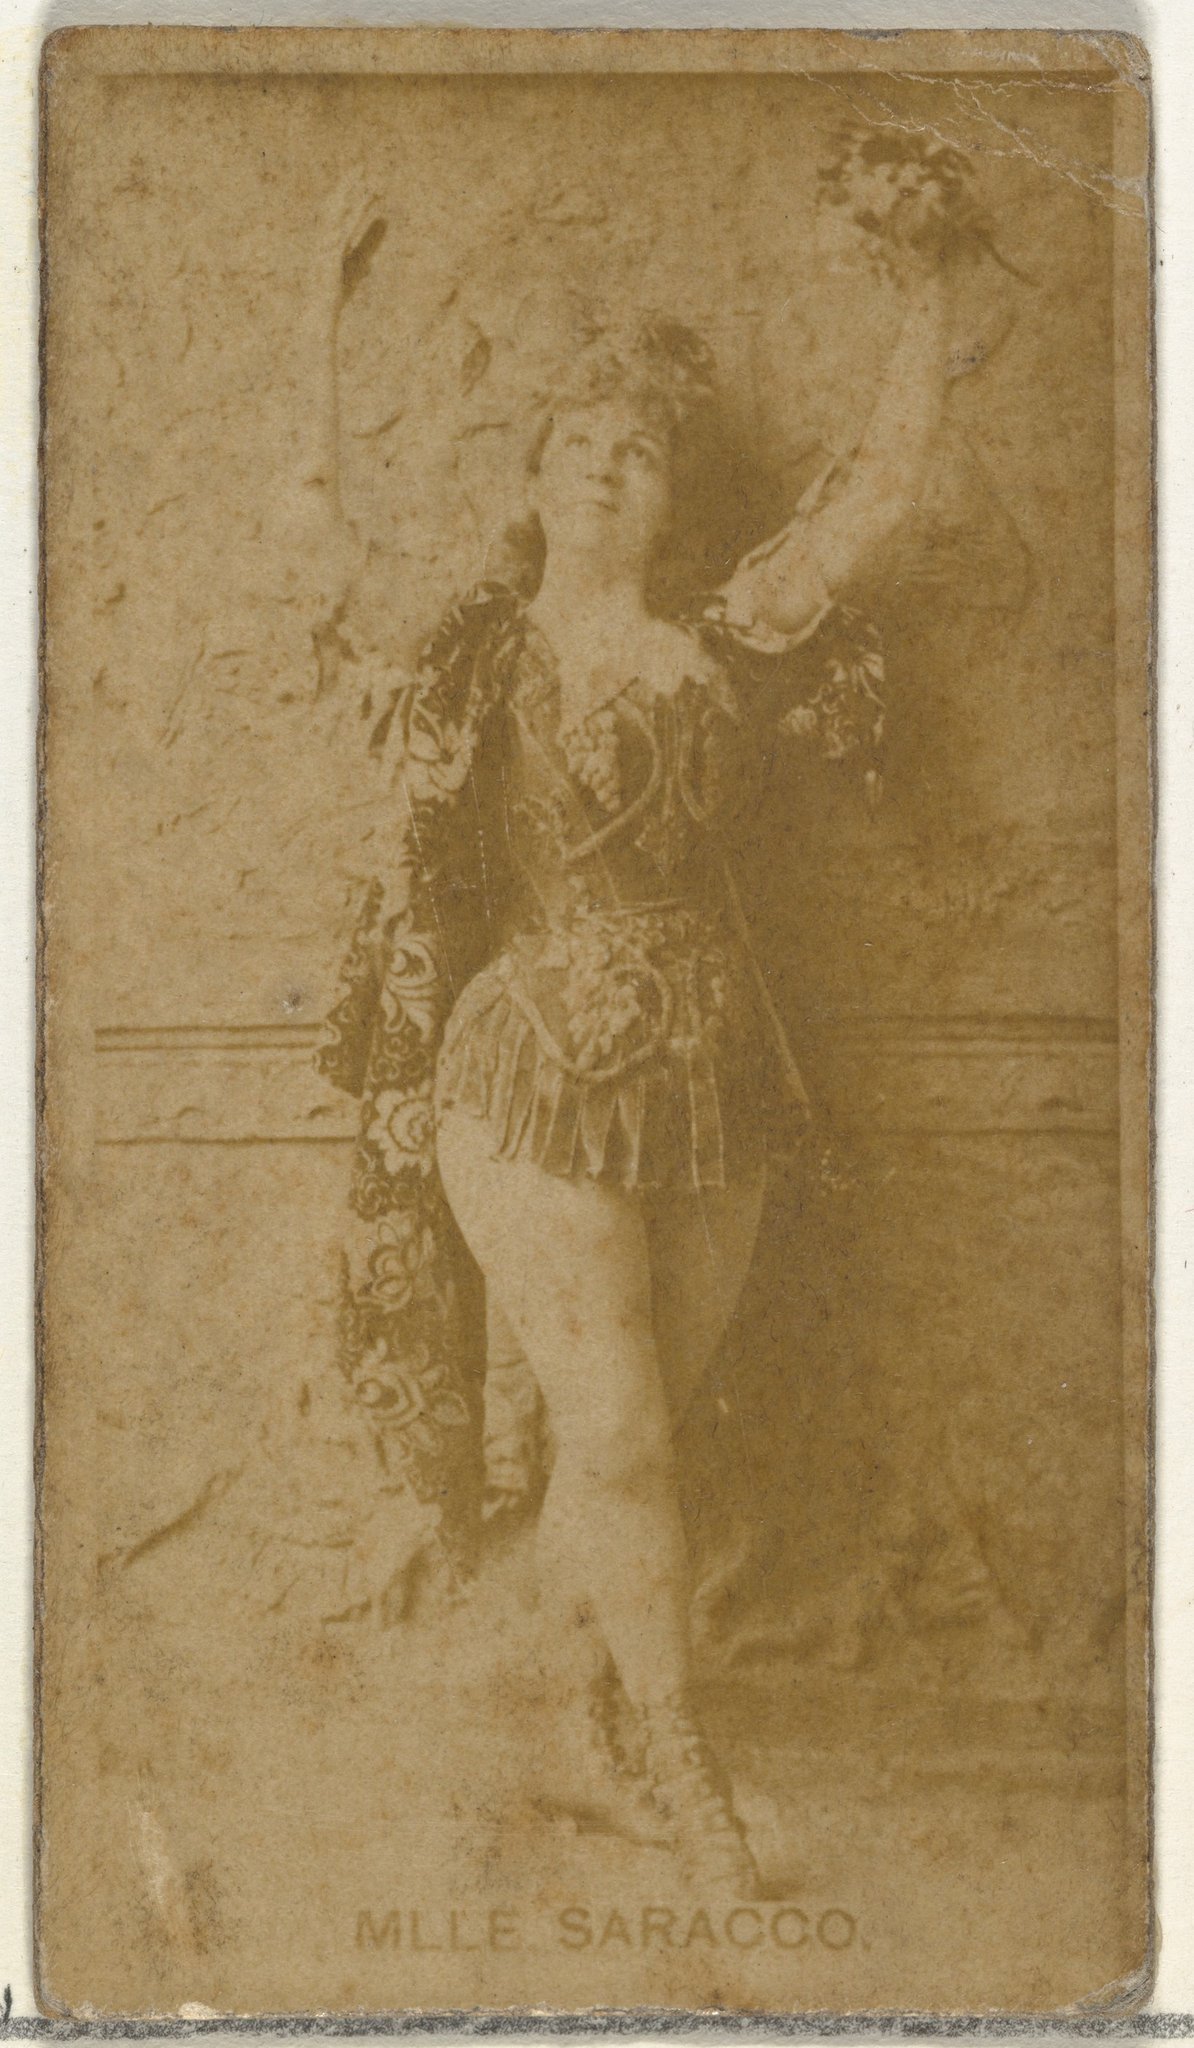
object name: photograph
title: Mlle. Saracco, from the Actors and Actresses series (N145-8) issued by Duke Sons & Co. to promote Duke Cigarettes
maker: w. duke, sons & co.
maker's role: publisher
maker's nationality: american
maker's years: 1870-1920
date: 1891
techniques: albumen silver print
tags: portraits,women,actresses